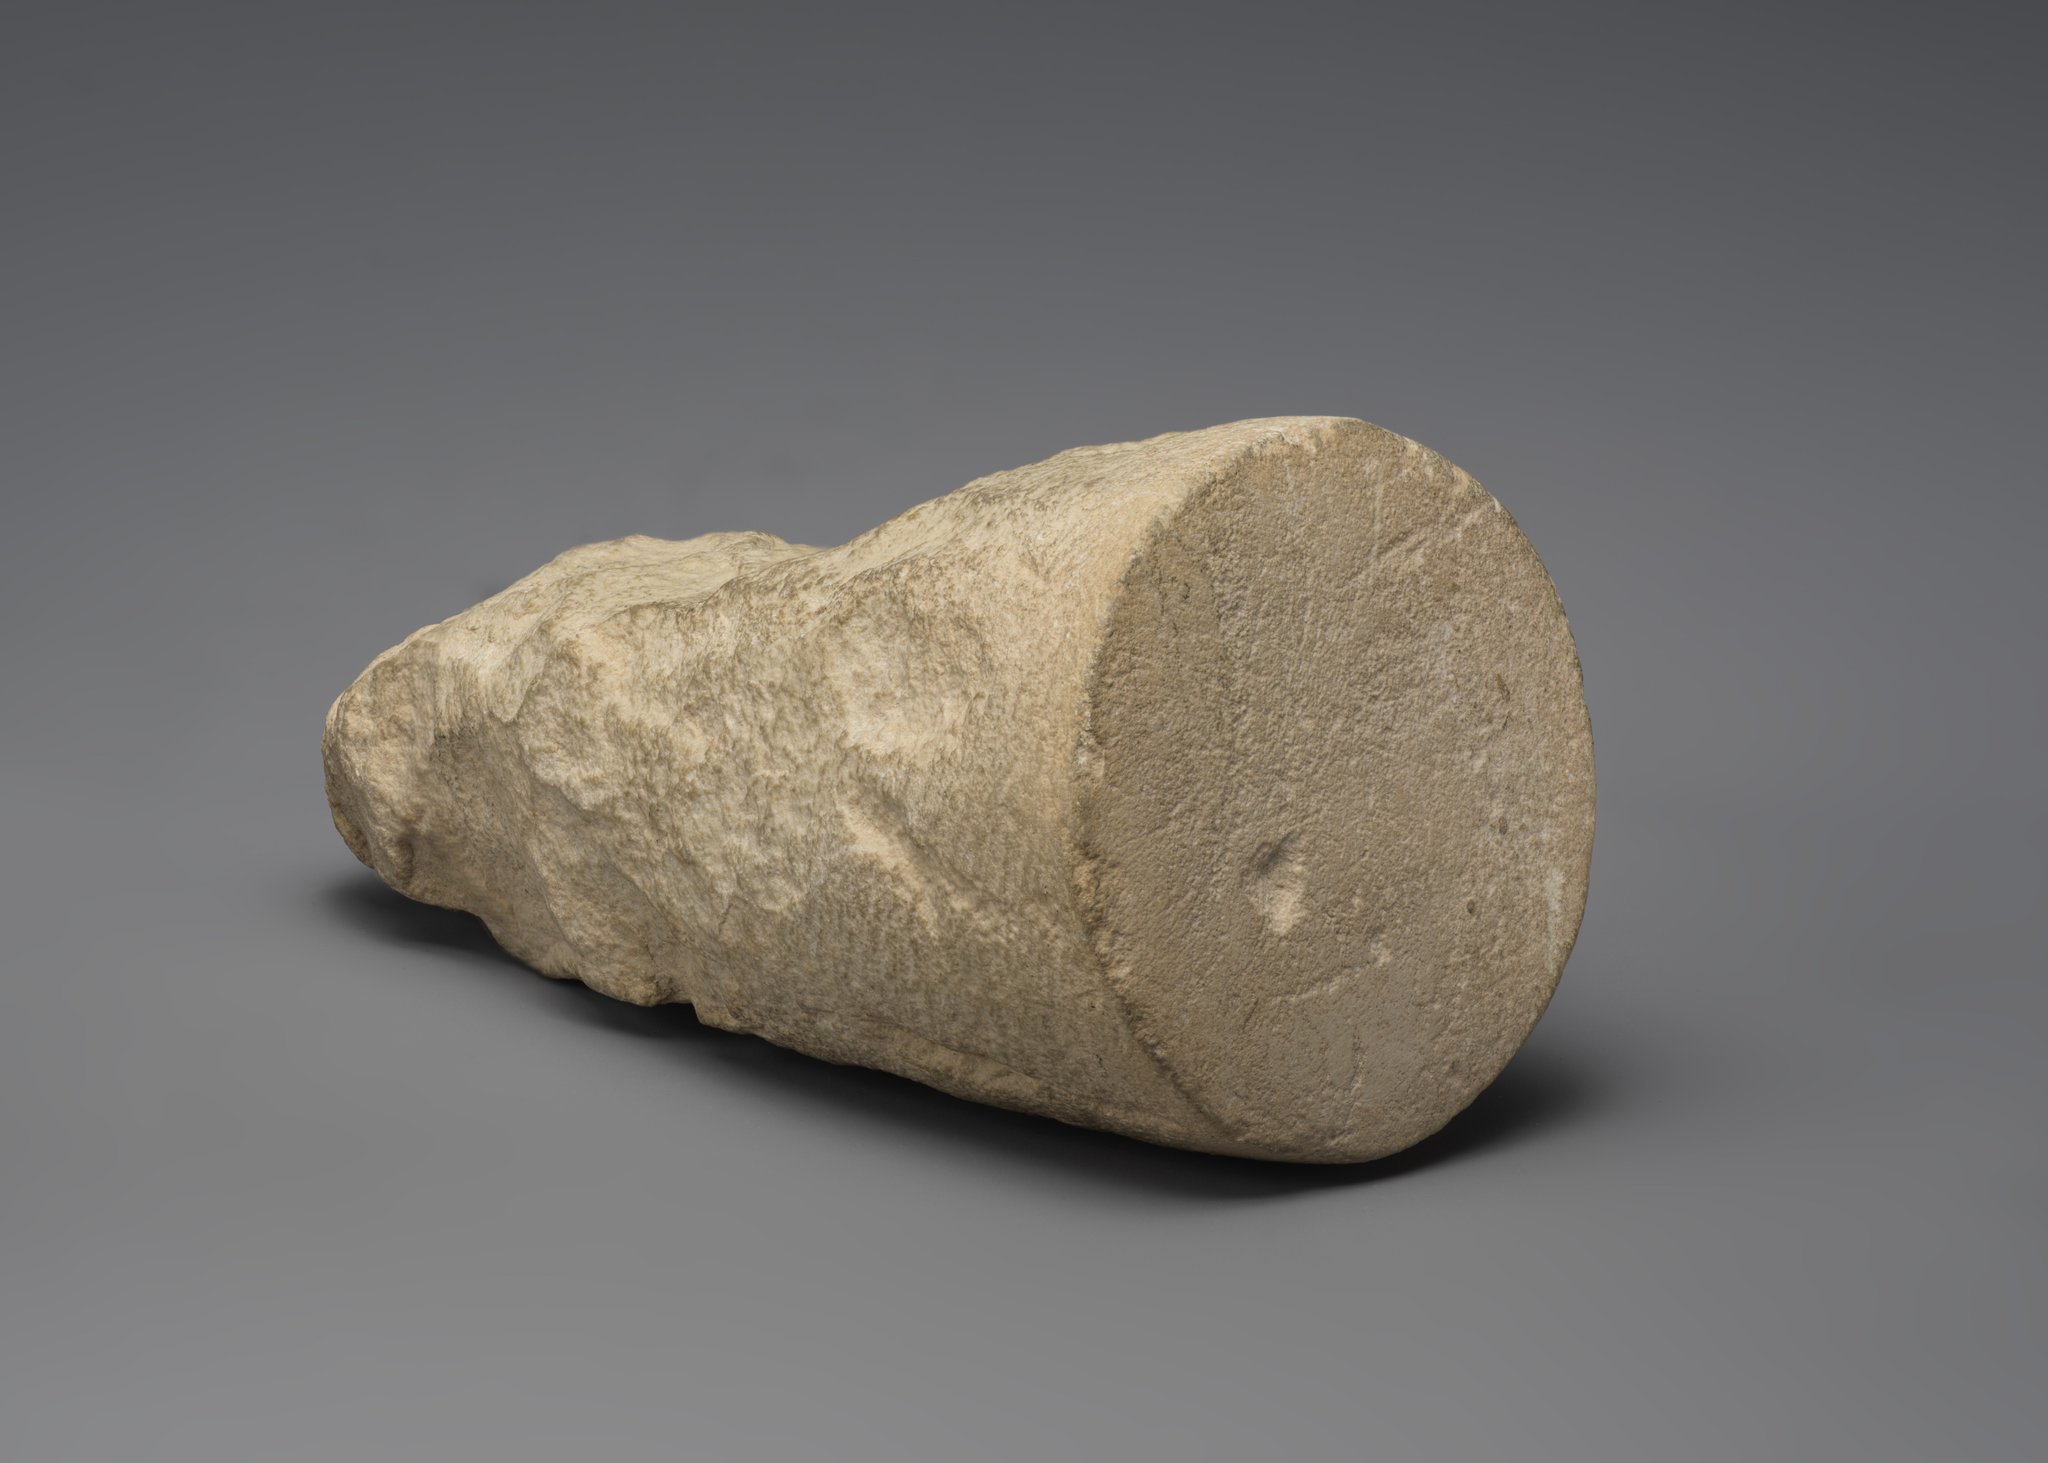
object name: mosaic cone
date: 3500-3100 BCE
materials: limestone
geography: southern mesopotamia